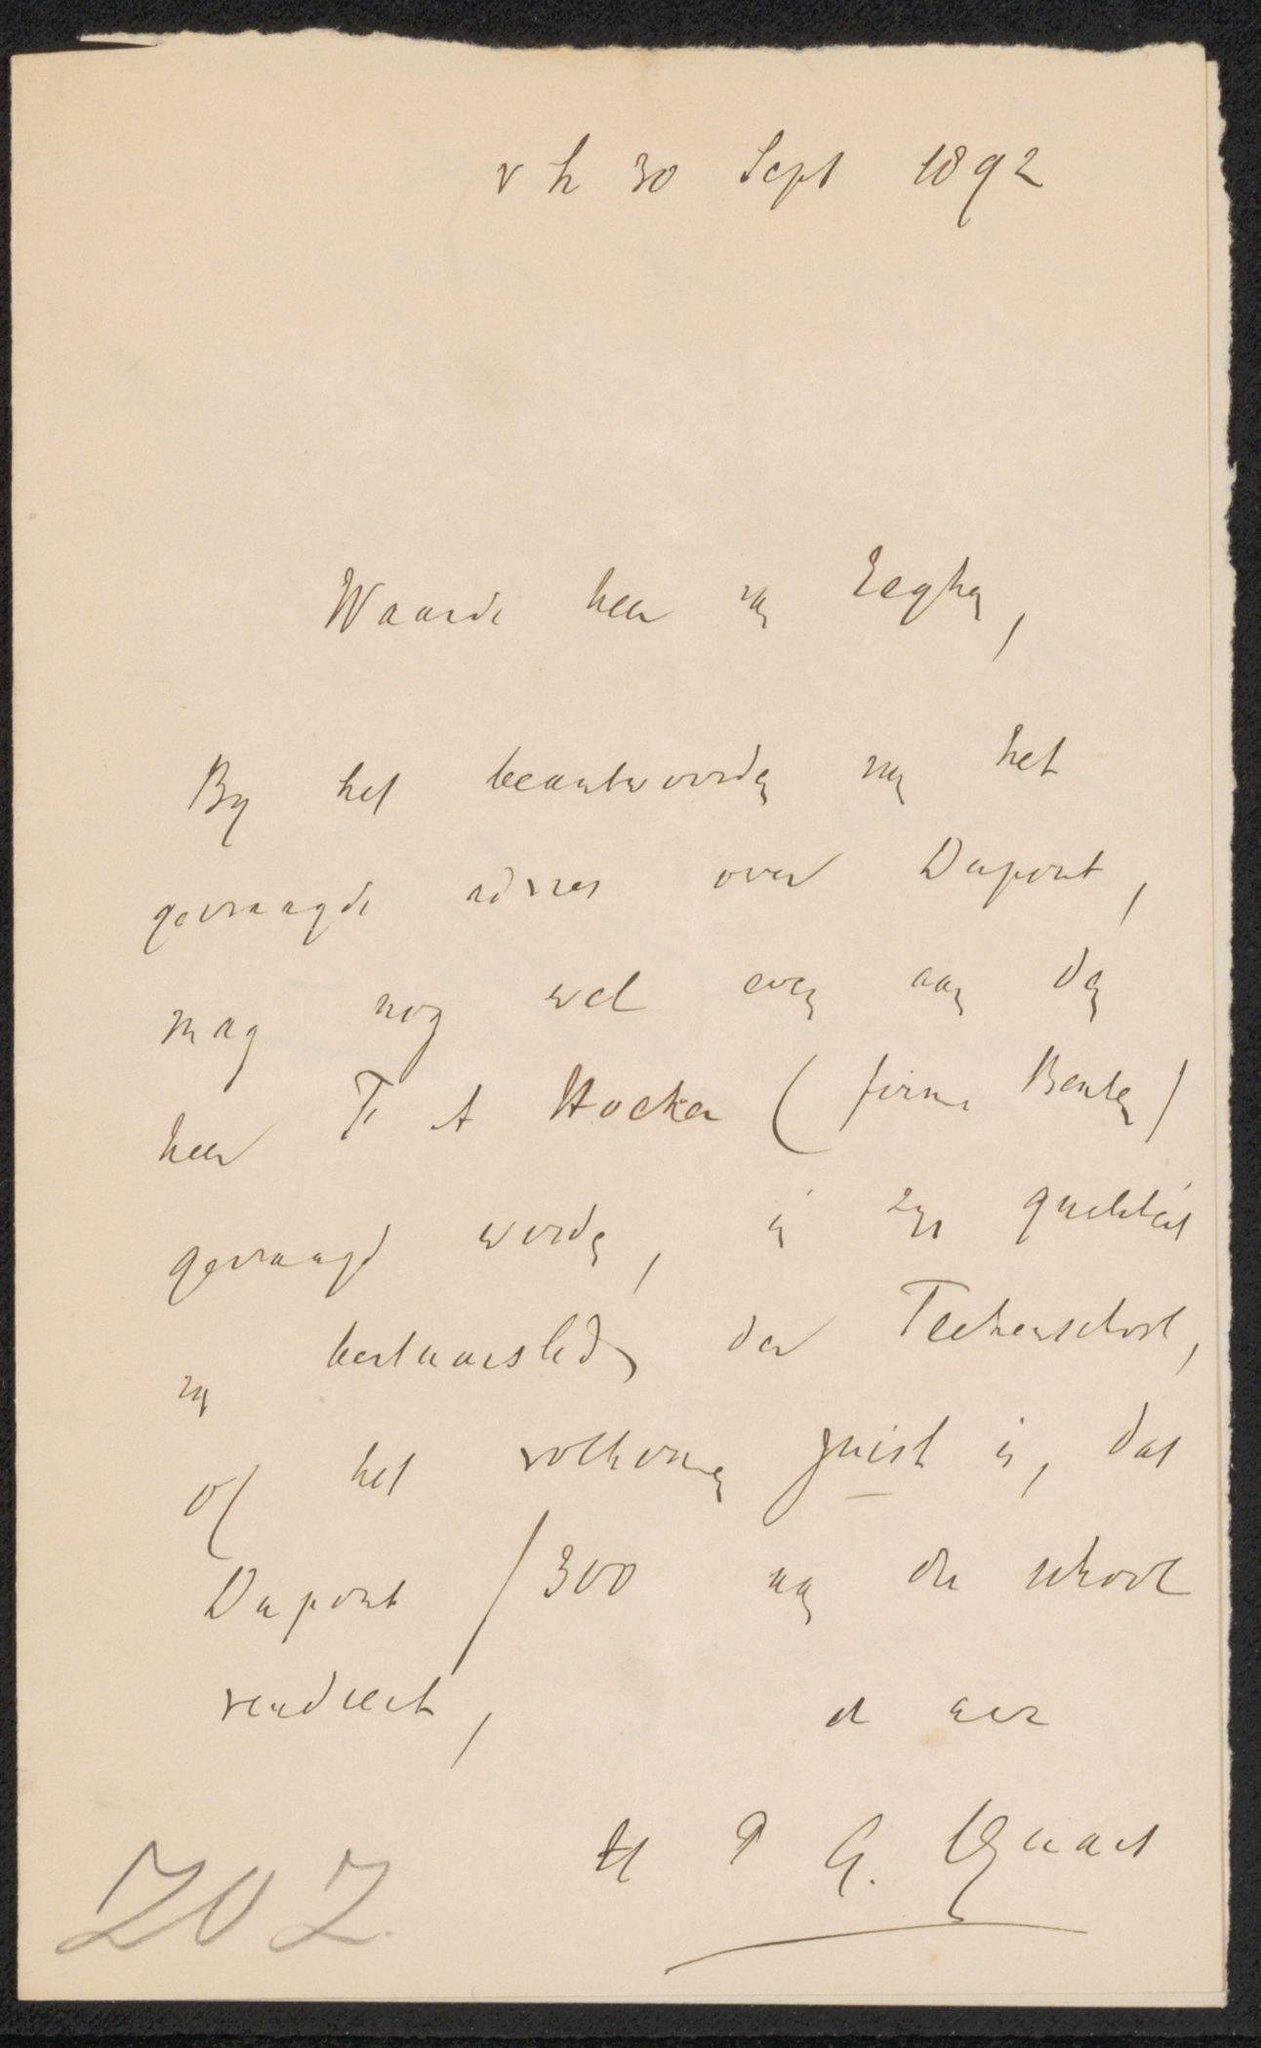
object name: letter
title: Brief aan Jan Herman van Eeghen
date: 1892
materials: ink, paper, pencil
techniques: pen, writing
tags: amsterdam, print maker, draughtsman, pieter dupont, education, tuition of the artist (in general), money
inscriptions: watermark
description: Brief bevat het antwoord van Jan Herman van Eeghen aan Hendrick Peter Godfried Quack.